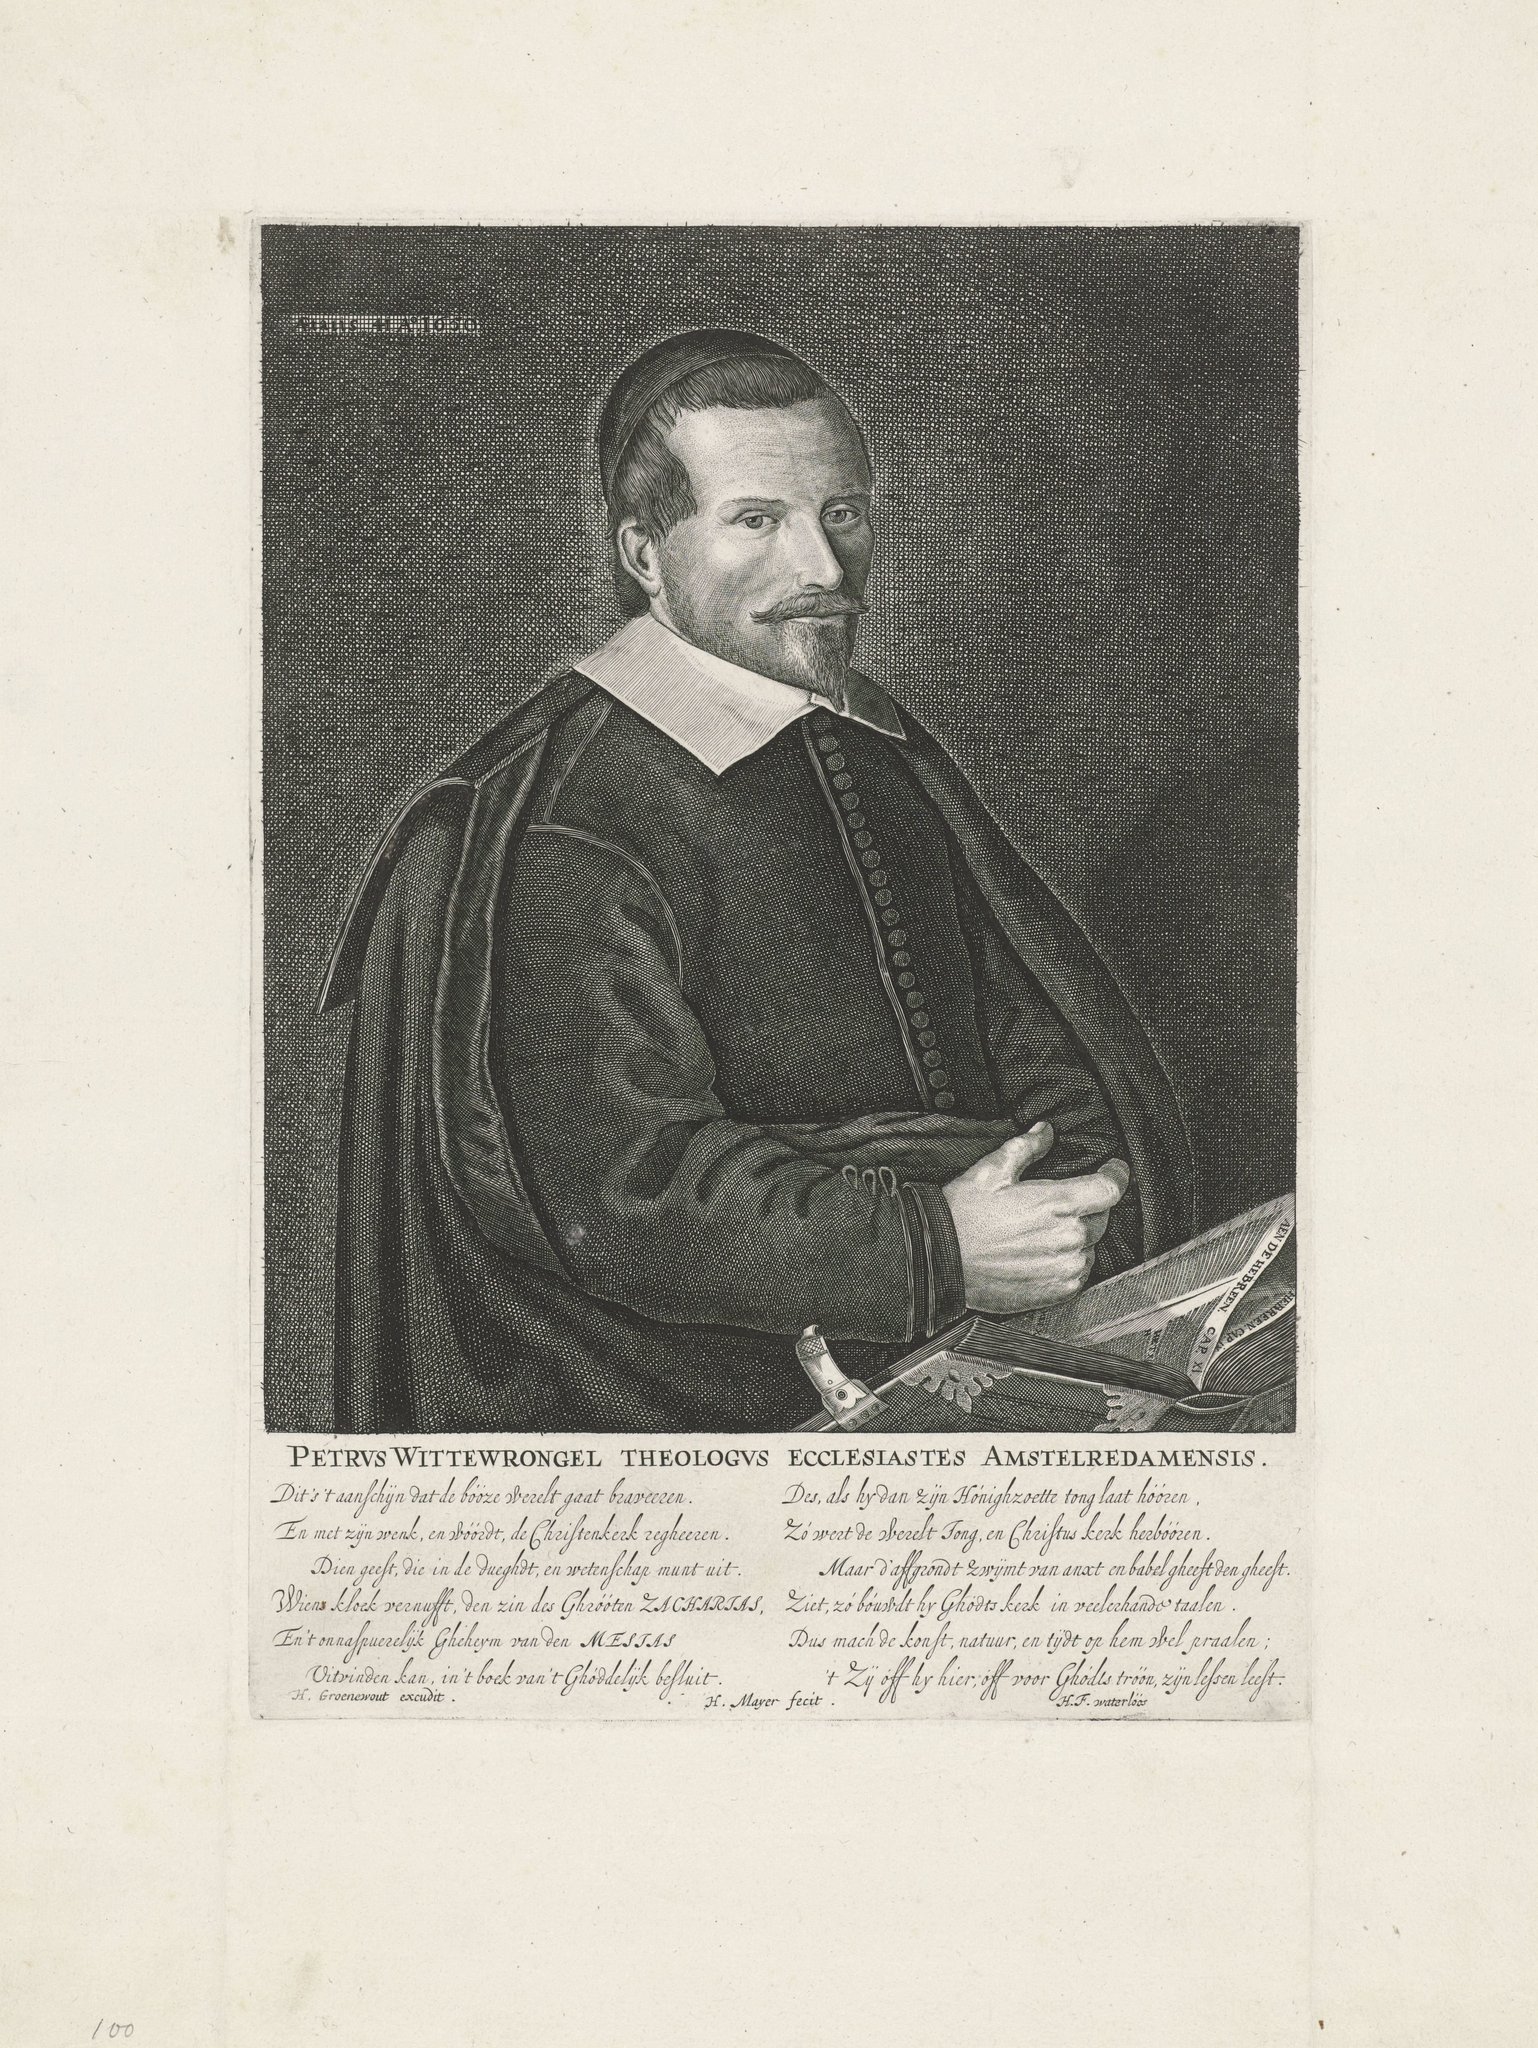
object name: print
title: Portret van Petrus Wittewrongel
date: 1650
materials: paper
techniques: engraving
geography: amsterdam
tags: middelburg, book - mm - book open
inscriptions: collector's mark: Lugt 240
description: Portret van predikant Petrus Wittewrongel bij een opengeslagen Bijbel op 41-jarige leeftijd. Onderaan in de marge een vers in het Nederlands.